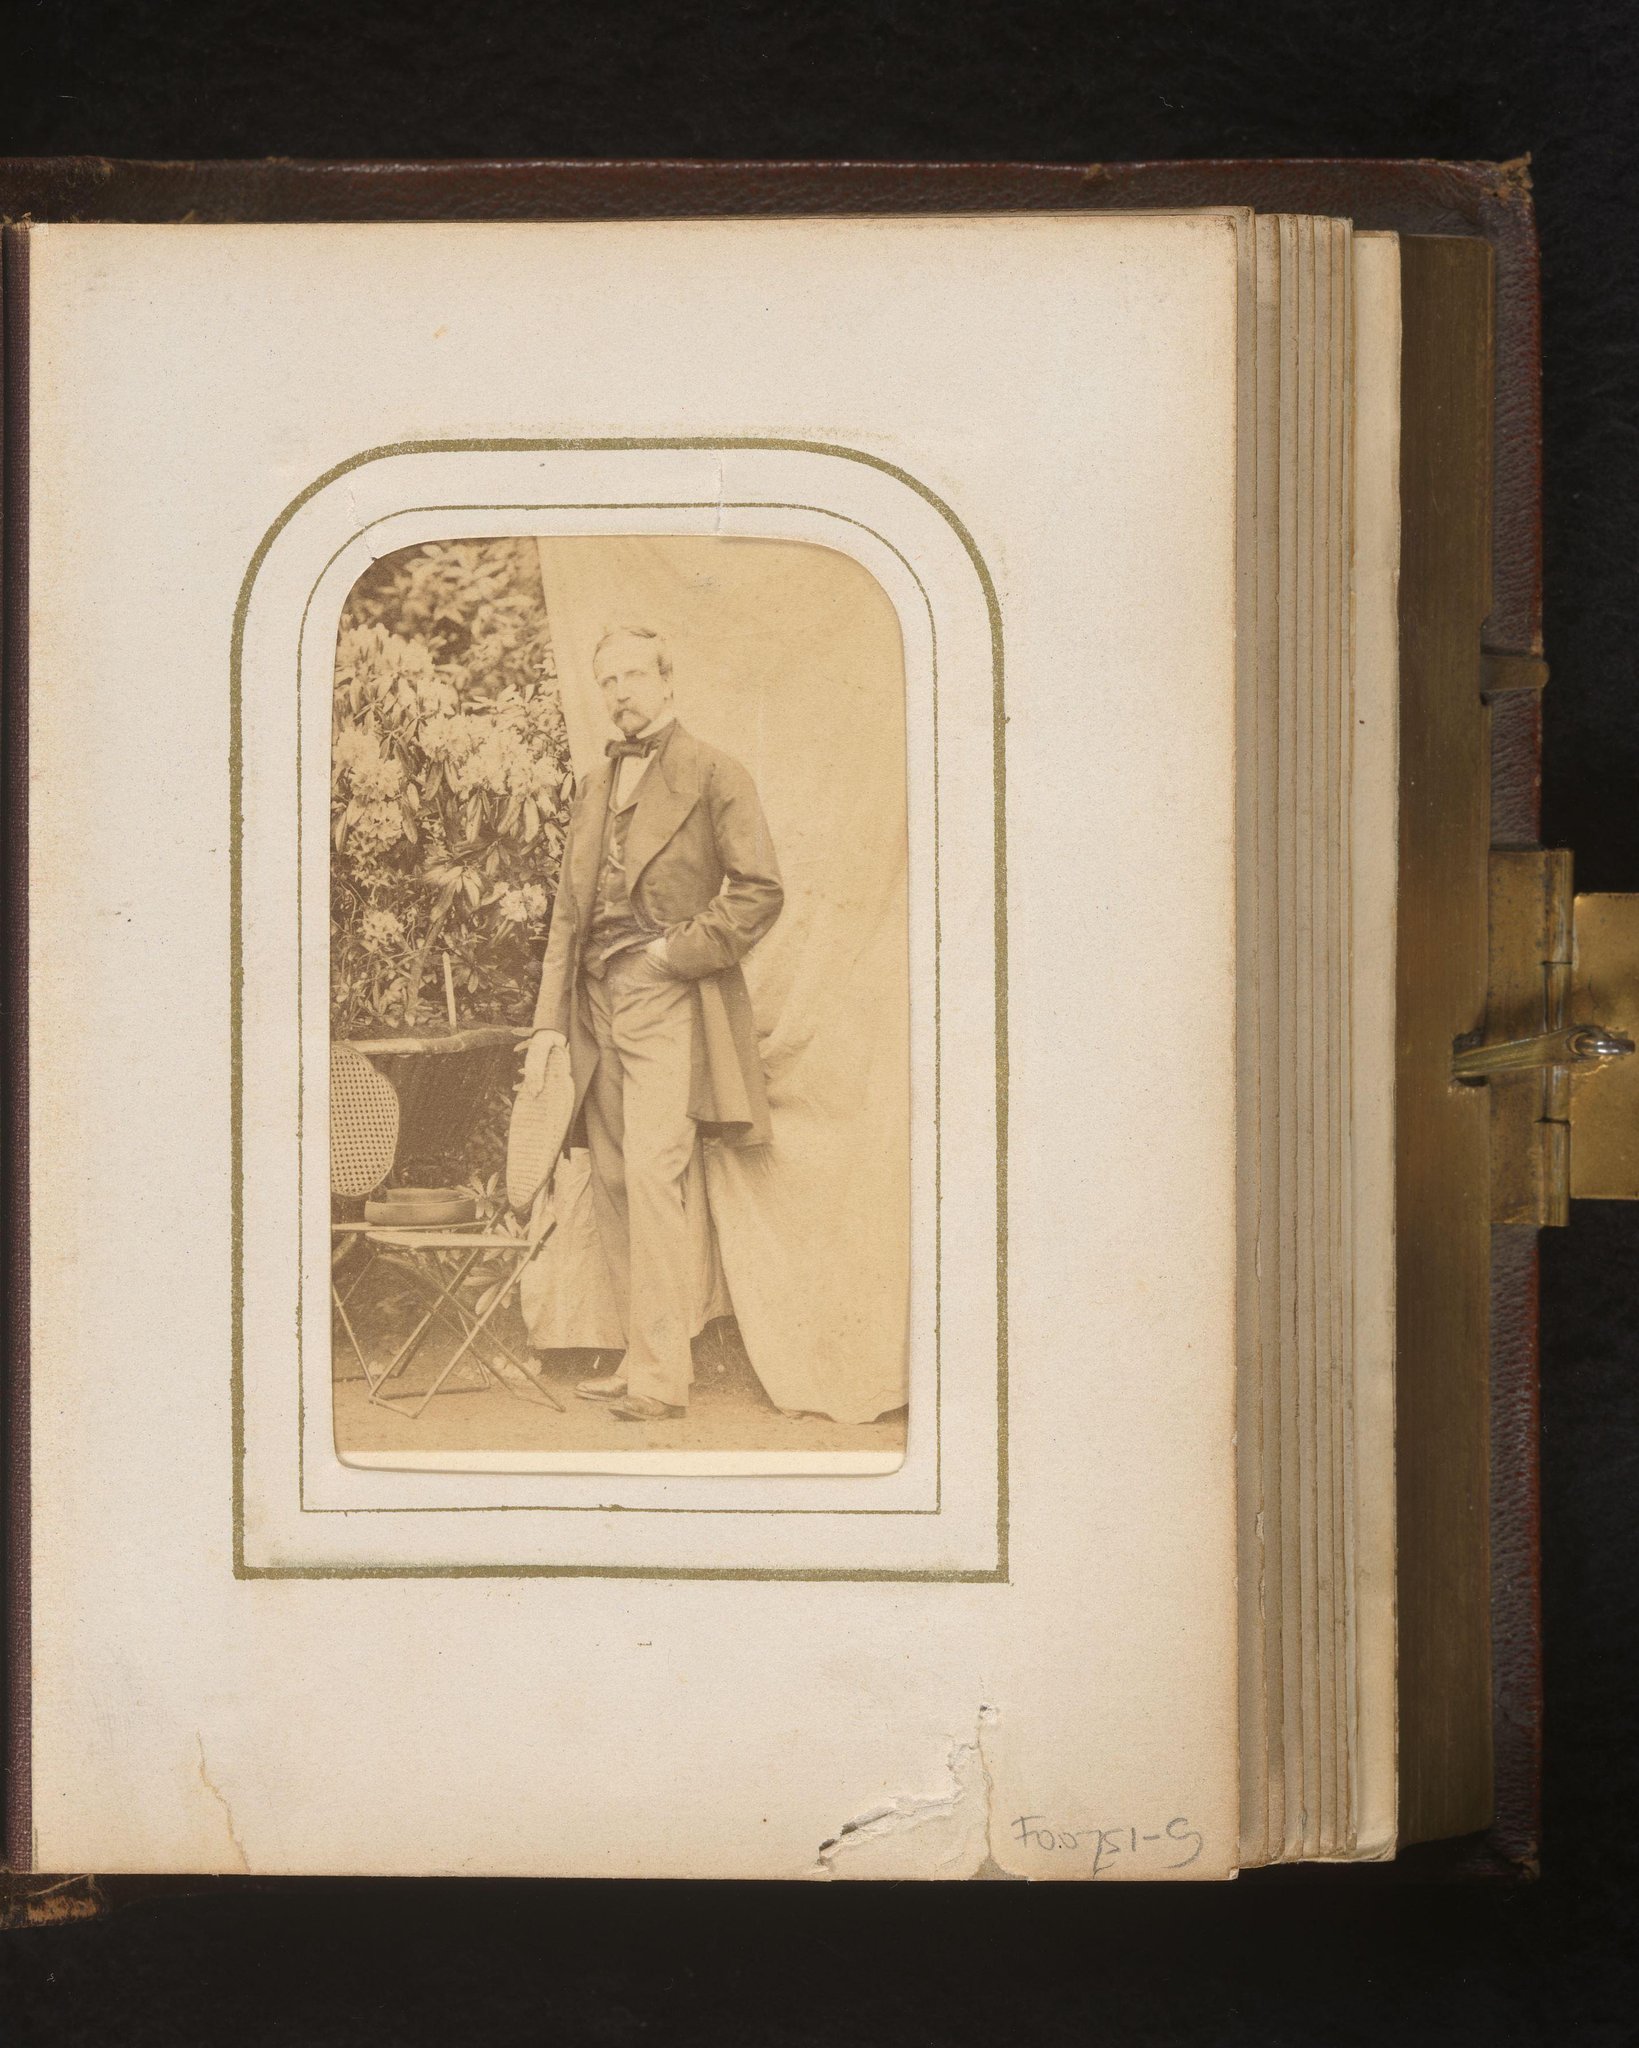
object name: carte de visite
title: Portret van een staande man in tuin met tuinstoelen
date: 1860-1900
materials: cardboard, photographic support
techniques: albumen print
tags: standing figure, adult man, historical persons, chair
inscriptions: inscription: ‘Patronied by her majesty/Caldesi, Blandford & Co/ photographers/ 13 Pall Mall East/ London’